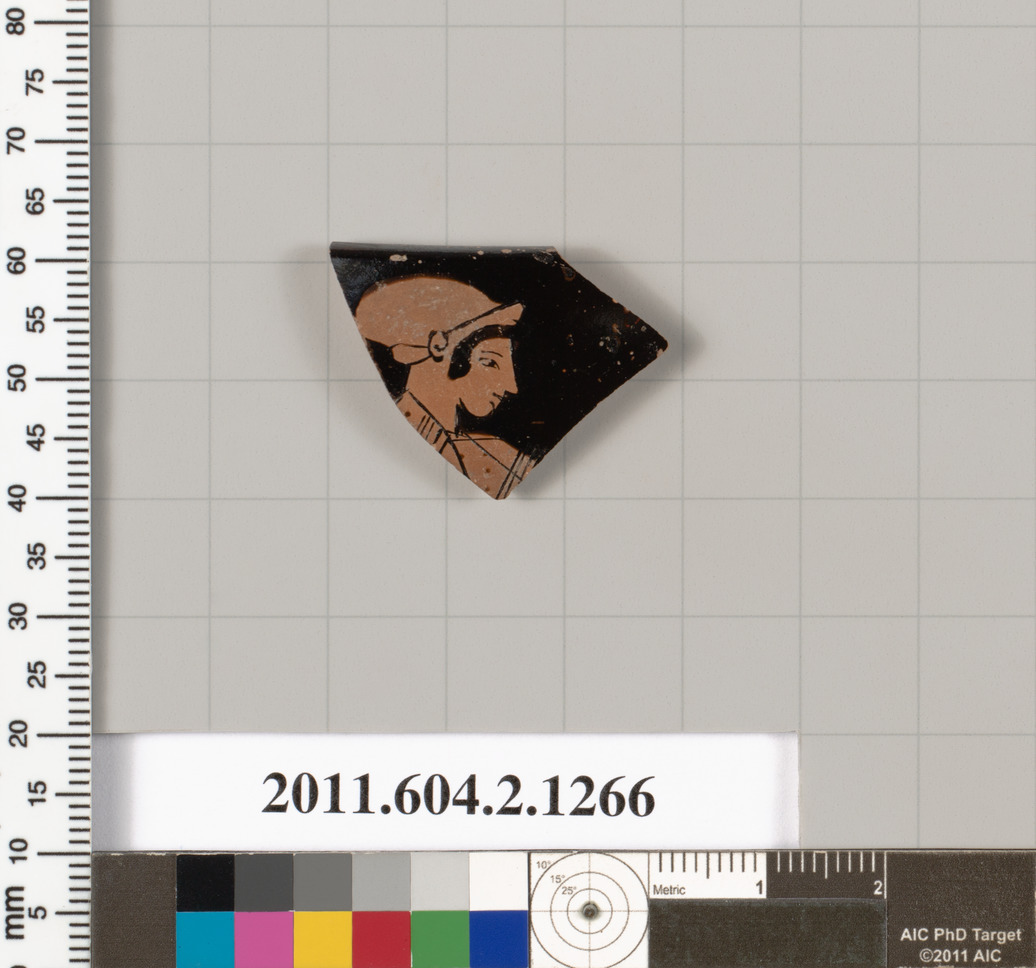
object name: skyphos fragment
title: Terracotta rim fragment of a skyphos (deep drinking cup)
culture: greek, attic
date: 475-451 BCE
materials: terracotta